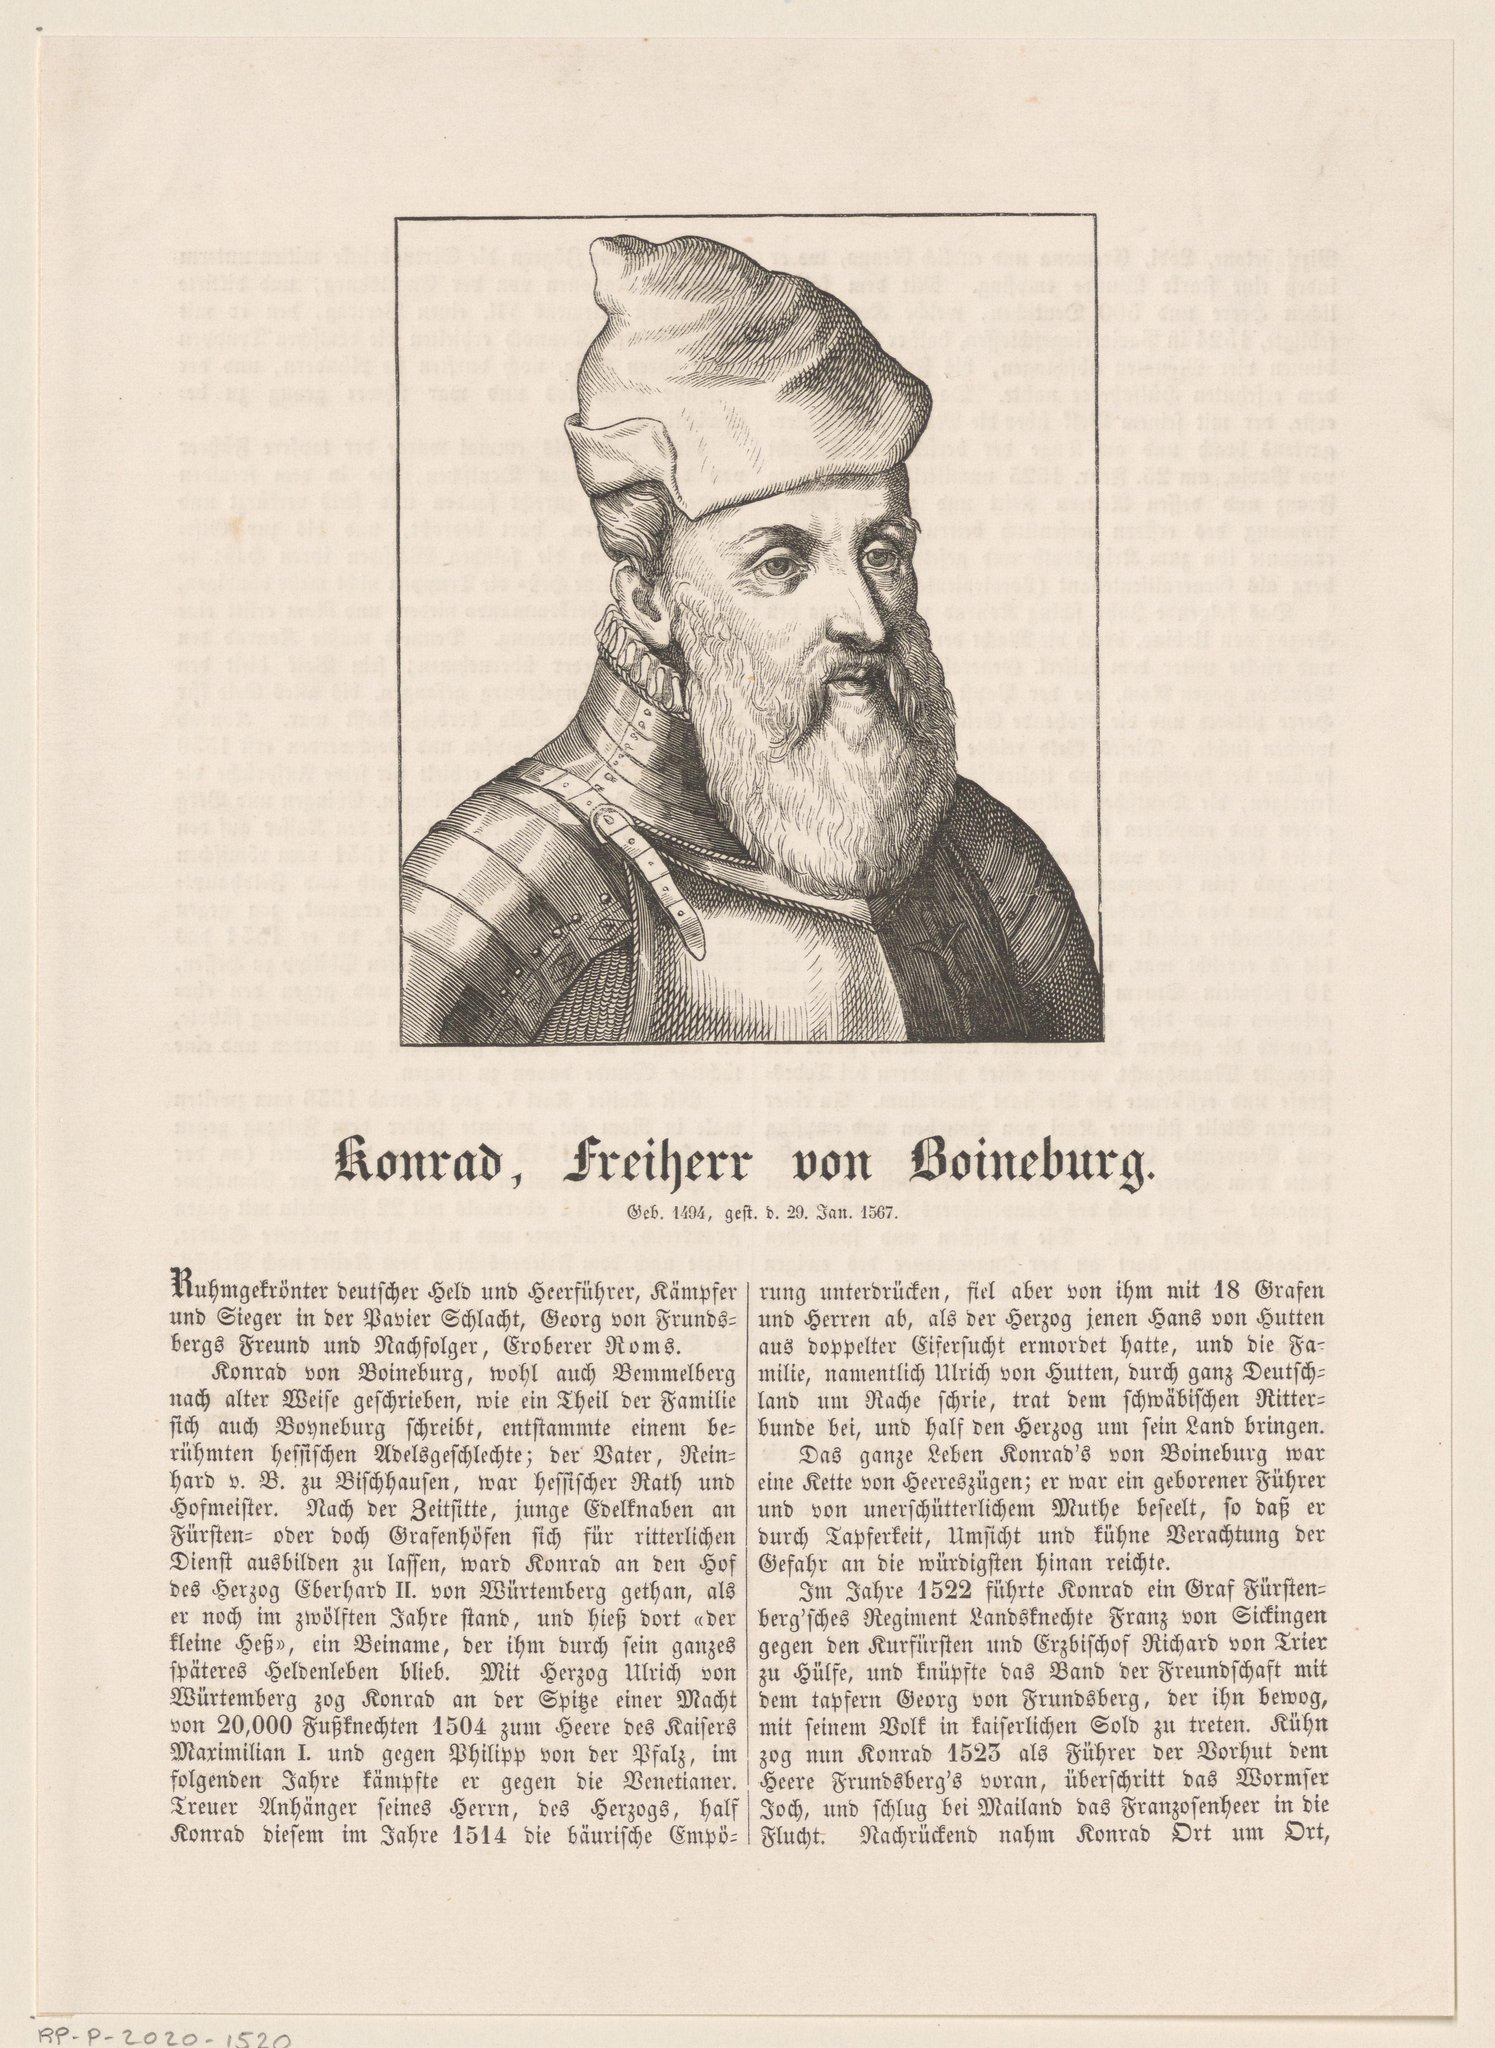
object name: book illustration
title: Portret van Konrad von Boineburg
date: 1854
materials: paper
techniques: letterpress printing, engraving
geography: leipzig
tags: commander-in-chief, general, marshal, historical persons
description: Prent uit: Bechstein, Ludwig. Zweihundert deutsche Männer in Bildnissen und Lebensbeschreibungen. Leipzig: Georg Wigand, 1854.